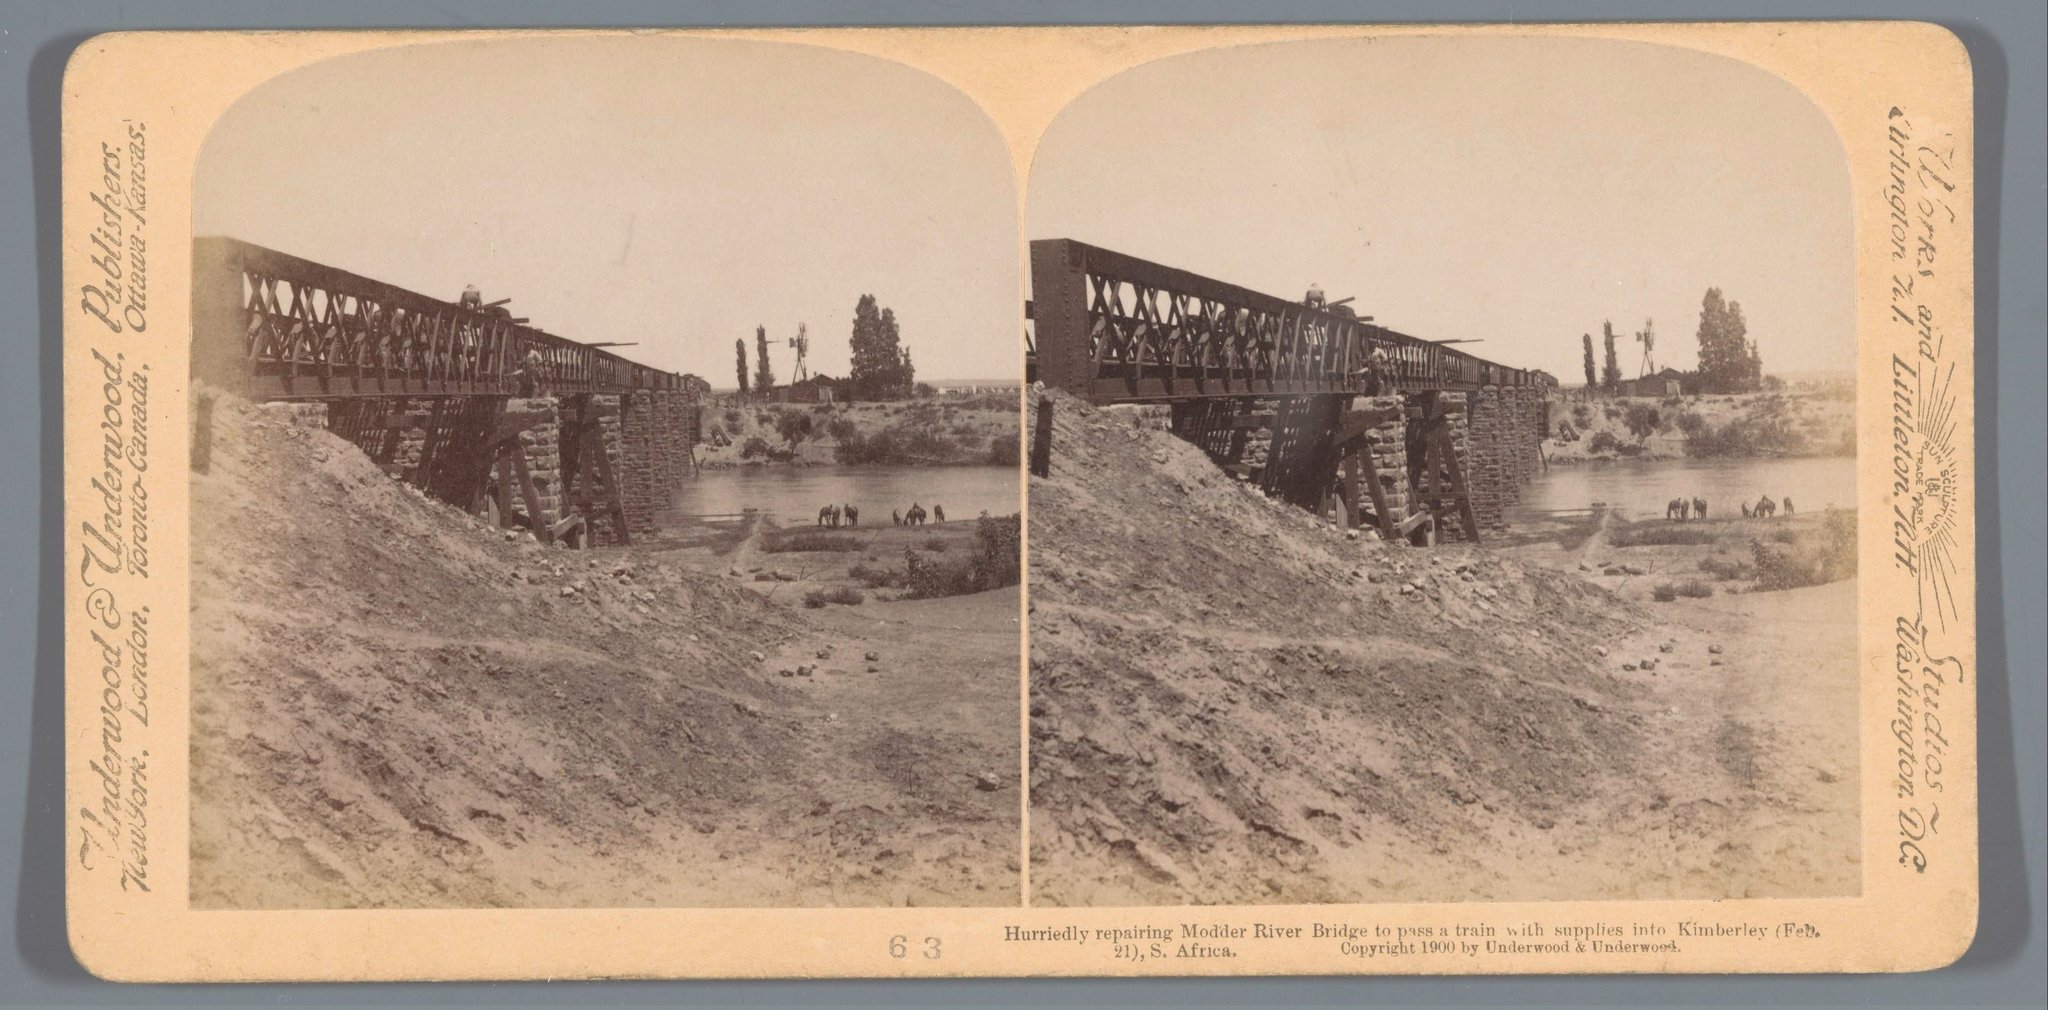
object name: stereograph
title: Hurriedly repairing Modder River Bridge to pass a train with supplies into Kimberly (Feb. 21), S. Africa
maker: Anonymous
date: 1900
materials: cardboard, paper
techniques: albumen print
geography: modderrivier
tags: landscape with bridge, viaduct or aqueduct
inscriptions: inscription, inscription: ‘Works and Studios ~/ Arlington, N.J. Littleton, N.H. Washington, D.C.’, copyright notice: ‘Copyright 1900 by Underwood & Underwood.’, number: ‘63’